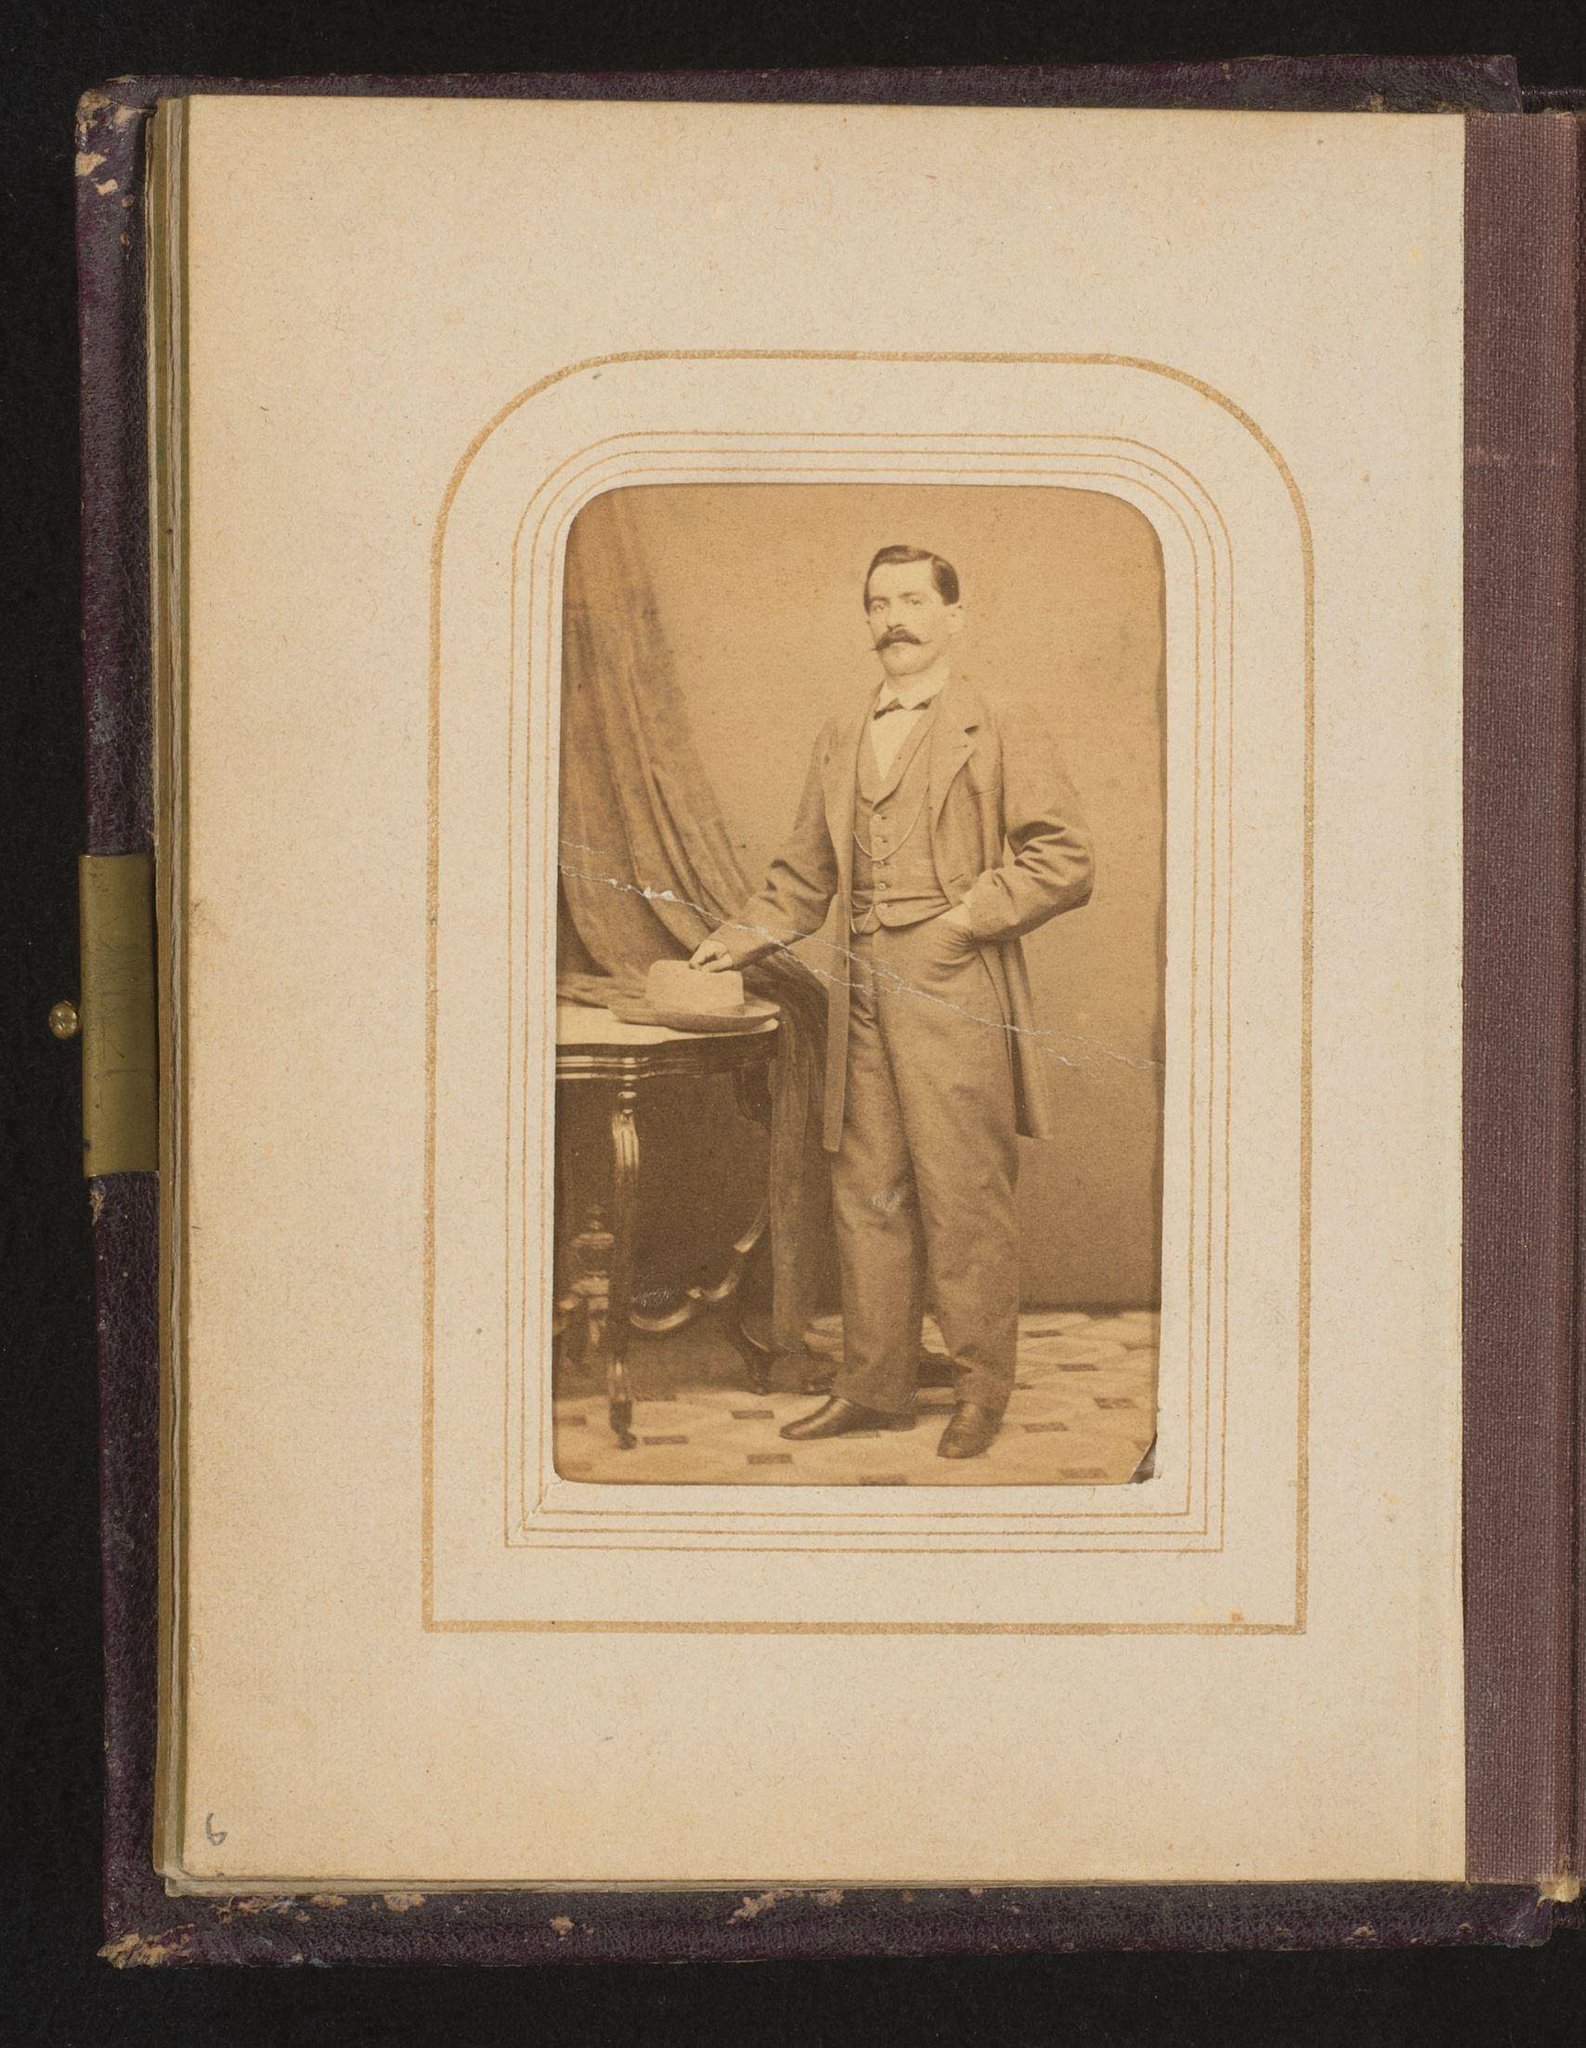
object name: photograph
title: Portret van een man met snor en hoed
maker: f. quiroga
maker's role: fotograaf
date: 1860-1900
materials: cardboard, photographic support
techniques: albumen print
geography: cuba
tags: moustache, historical persons, head-gear: hat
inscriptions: inscription: ‘F. Quiroga/ fotografo (y) retratista/ Isla de Cuba’